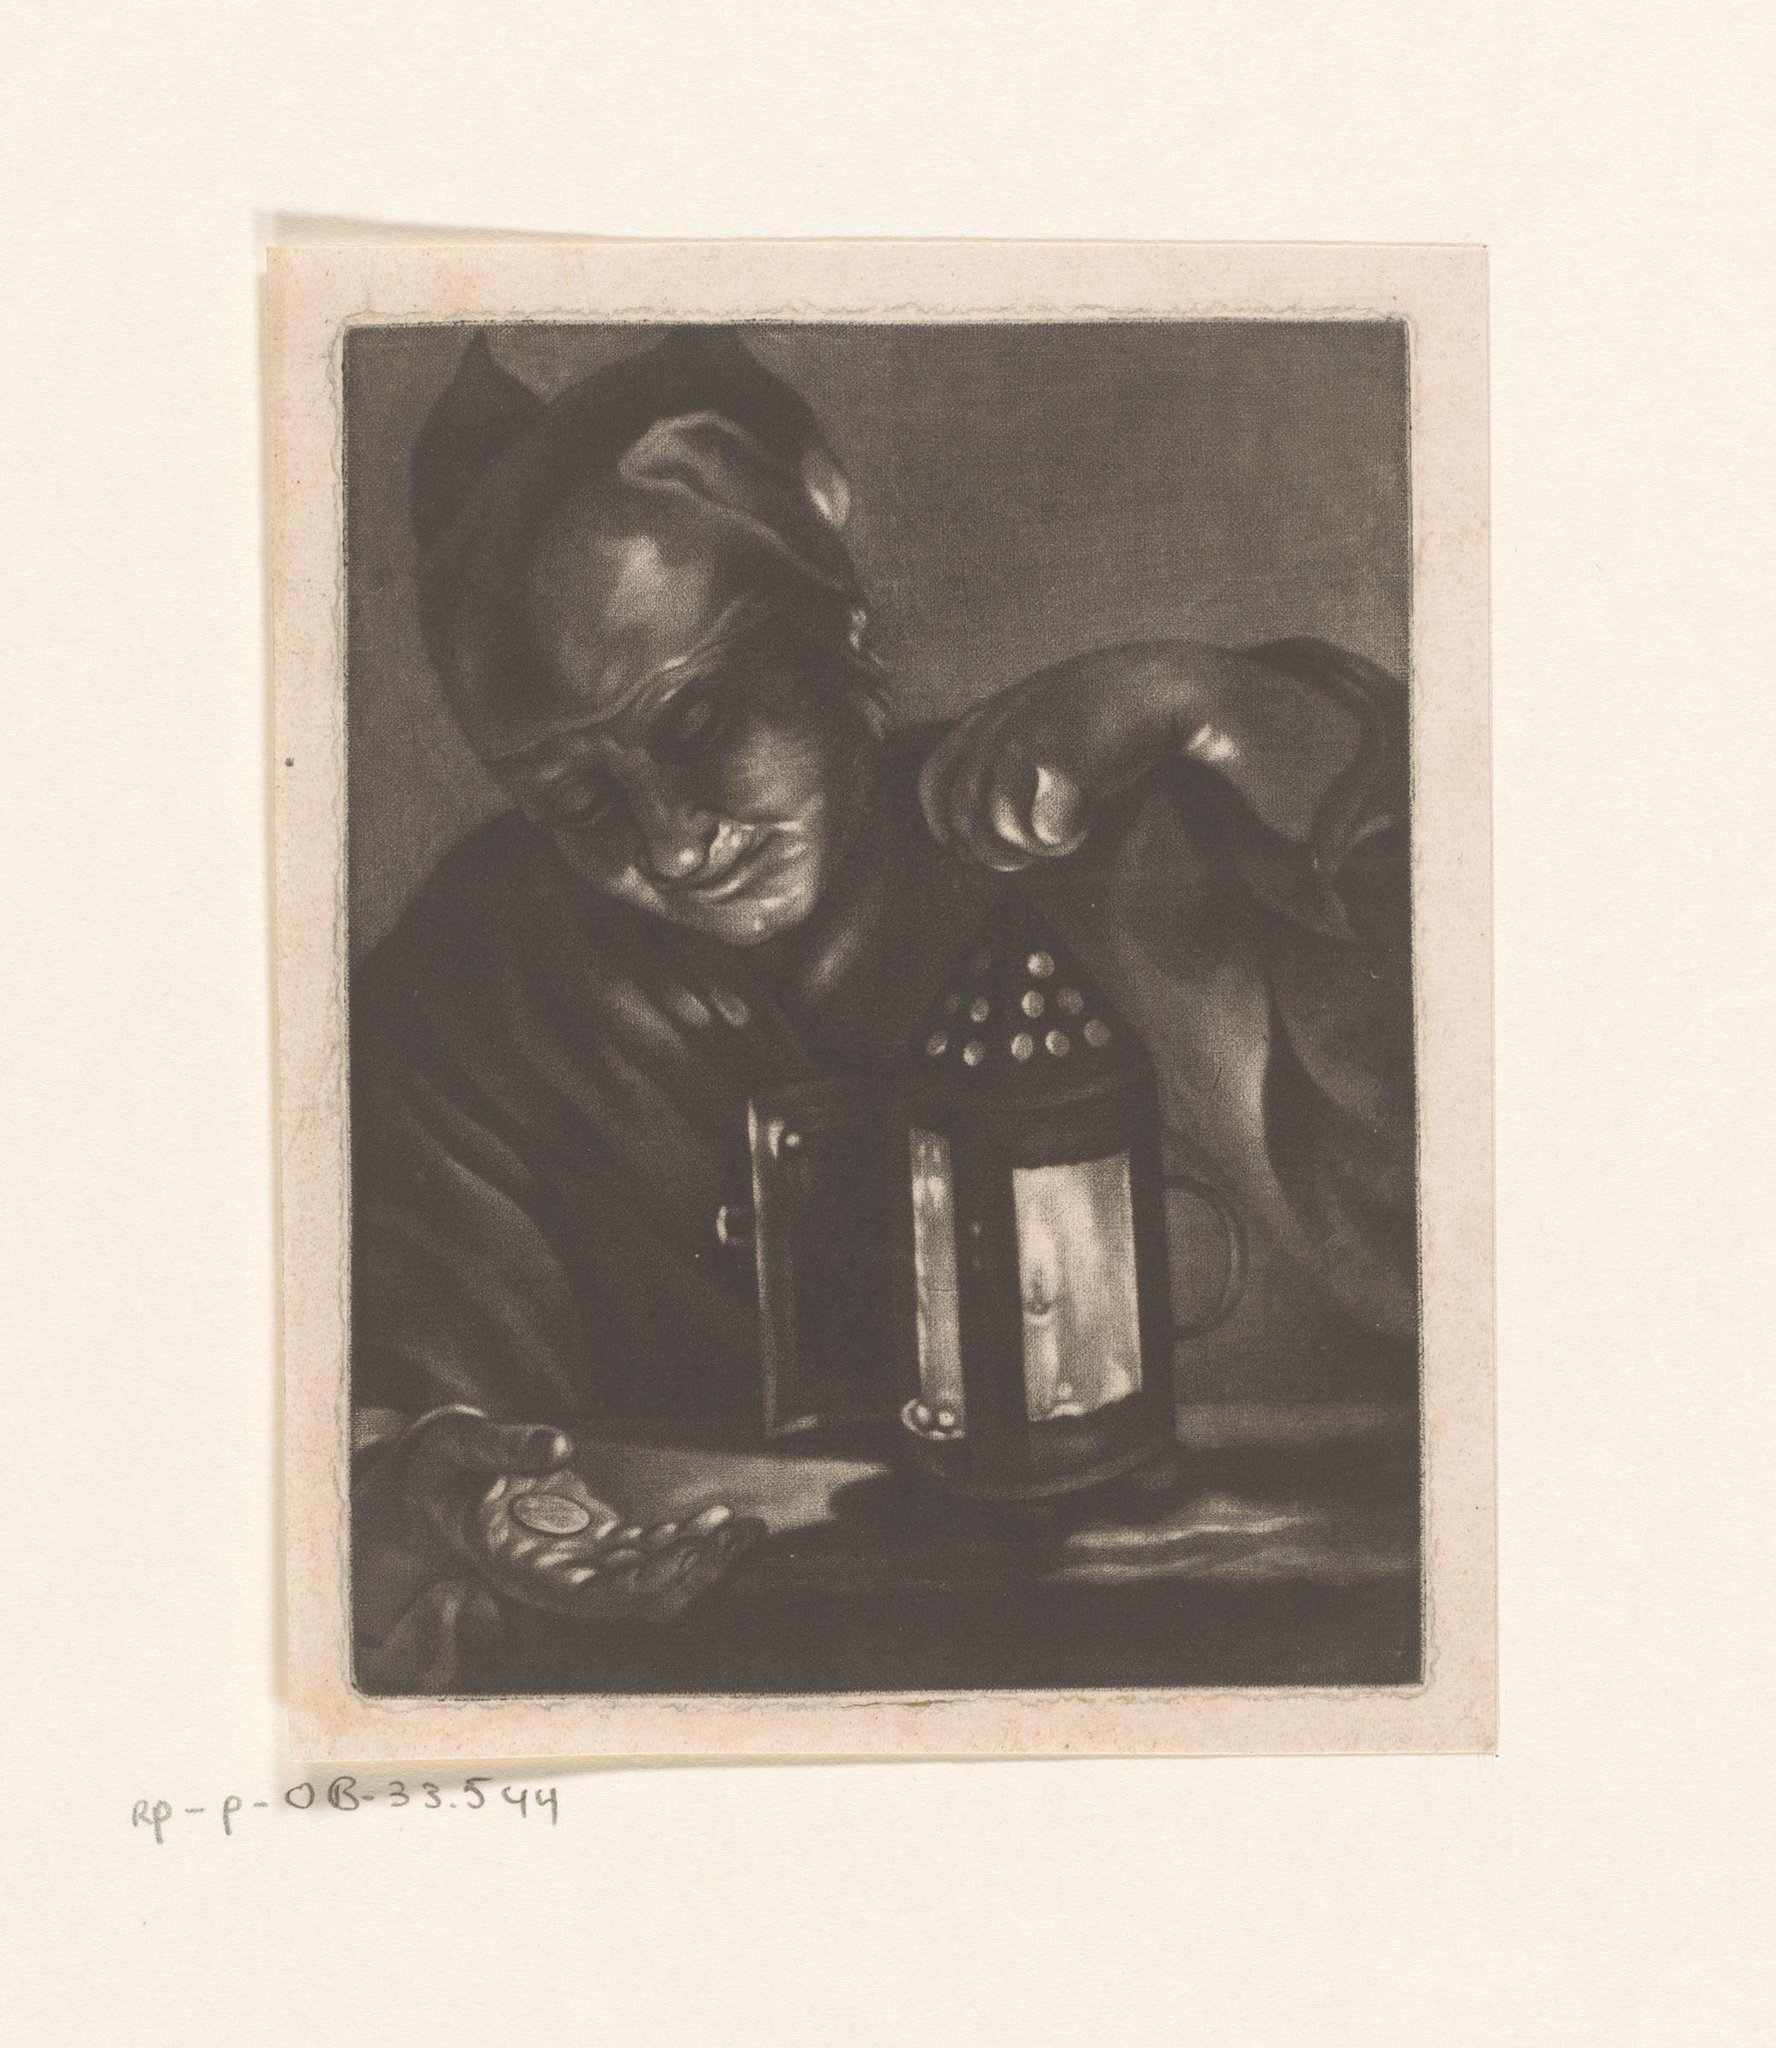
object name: print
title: Figuur bekijkt munt bij licht van een lantaarn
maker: Anonymous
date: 1700-1770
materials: paper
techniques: mezzotint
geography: england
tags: head-gear: cap, coin, lantern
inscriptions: collector's mark: Lugt 240